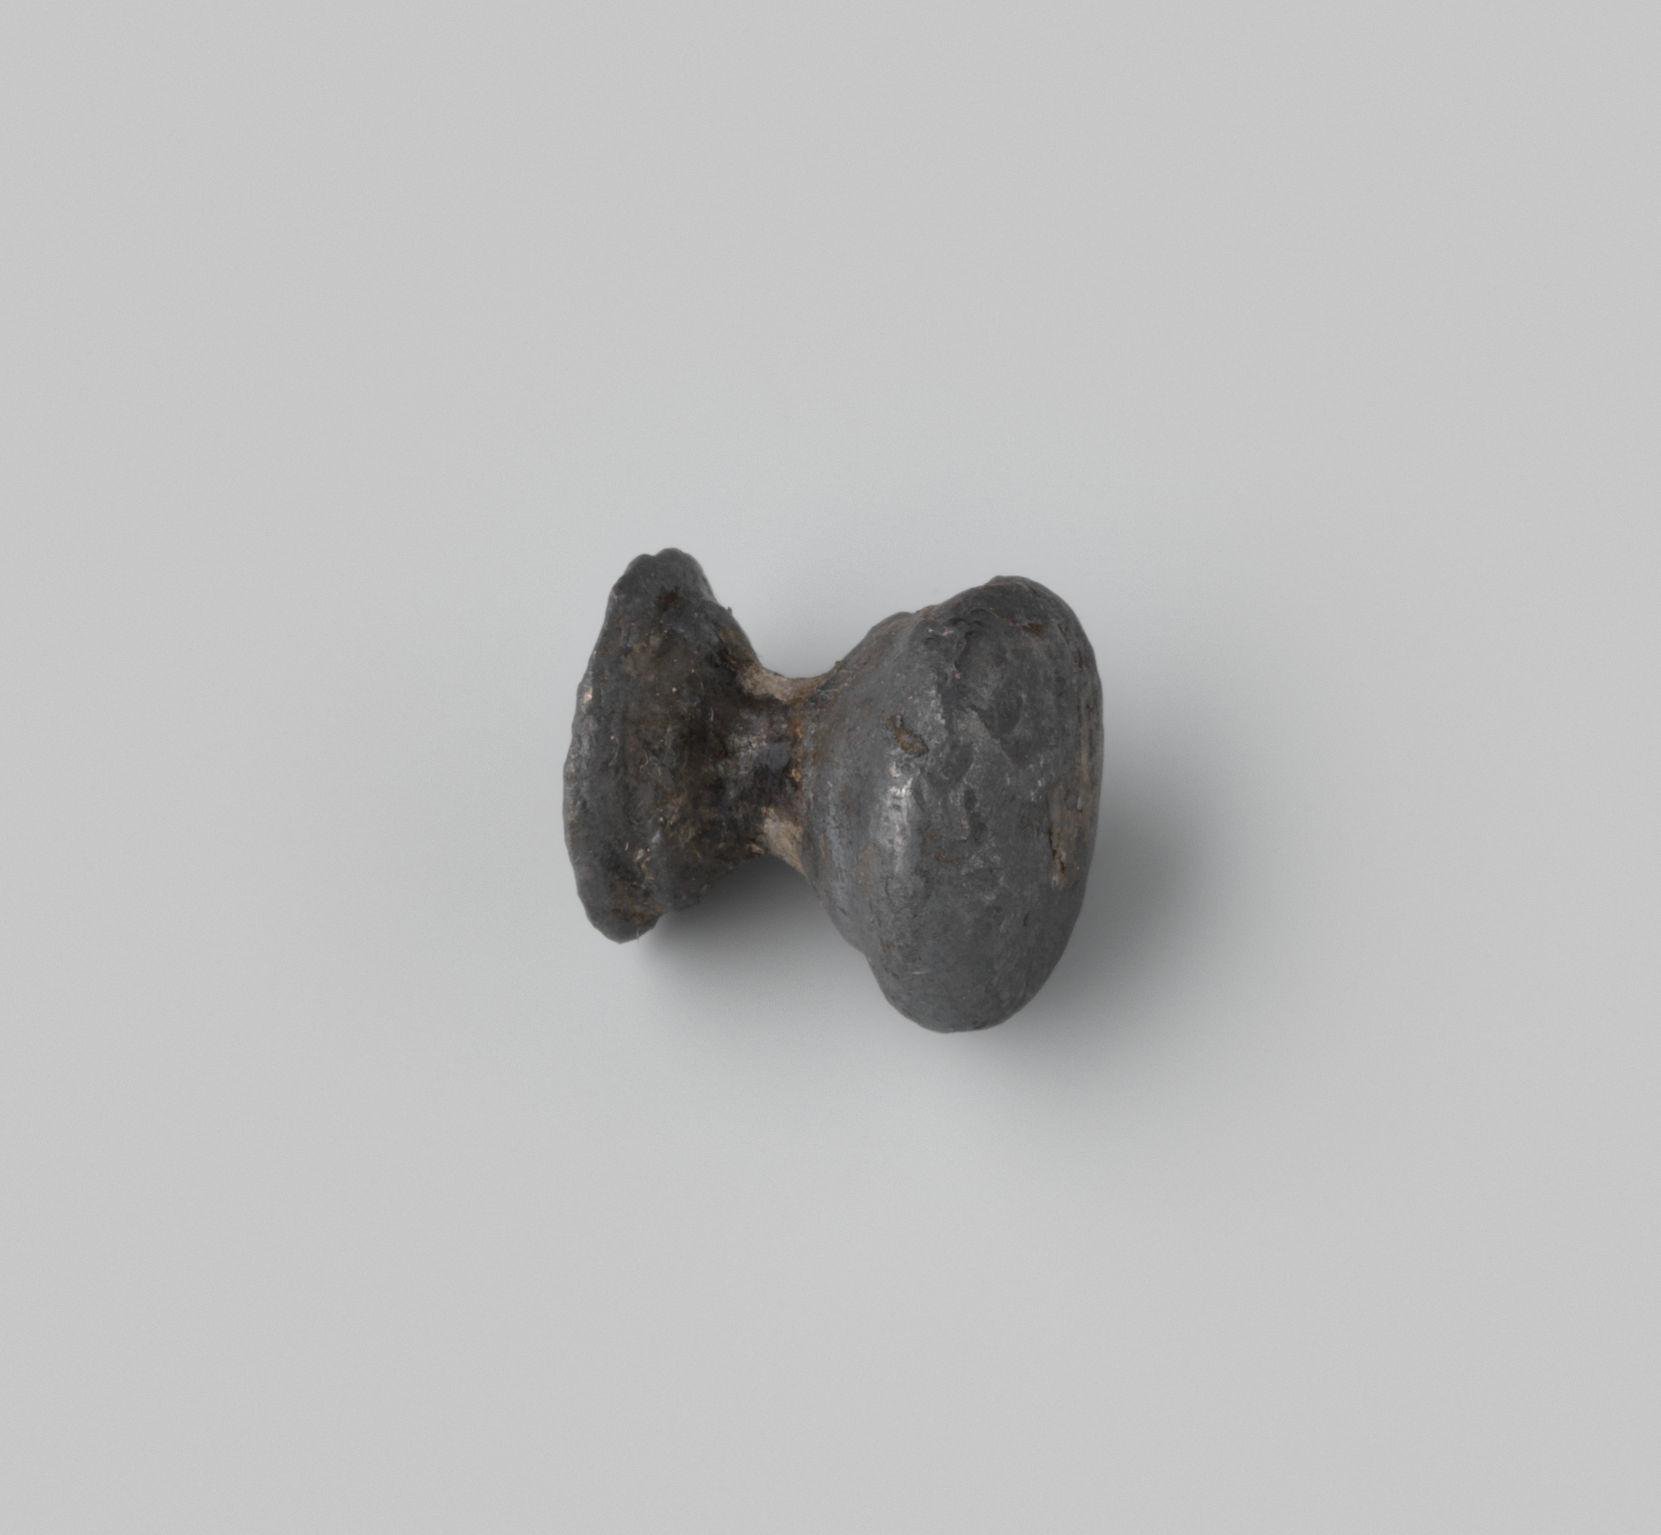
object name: knob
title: Knop uit het wrak van de Oost-Indiëvaarder Hollandia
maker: Anonymous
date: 1700-1743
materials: silver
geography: netherlands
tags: verenigde oostindische compagnie, hollandia (schip), annet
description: Fitting, knob; finial or foot, spherical.